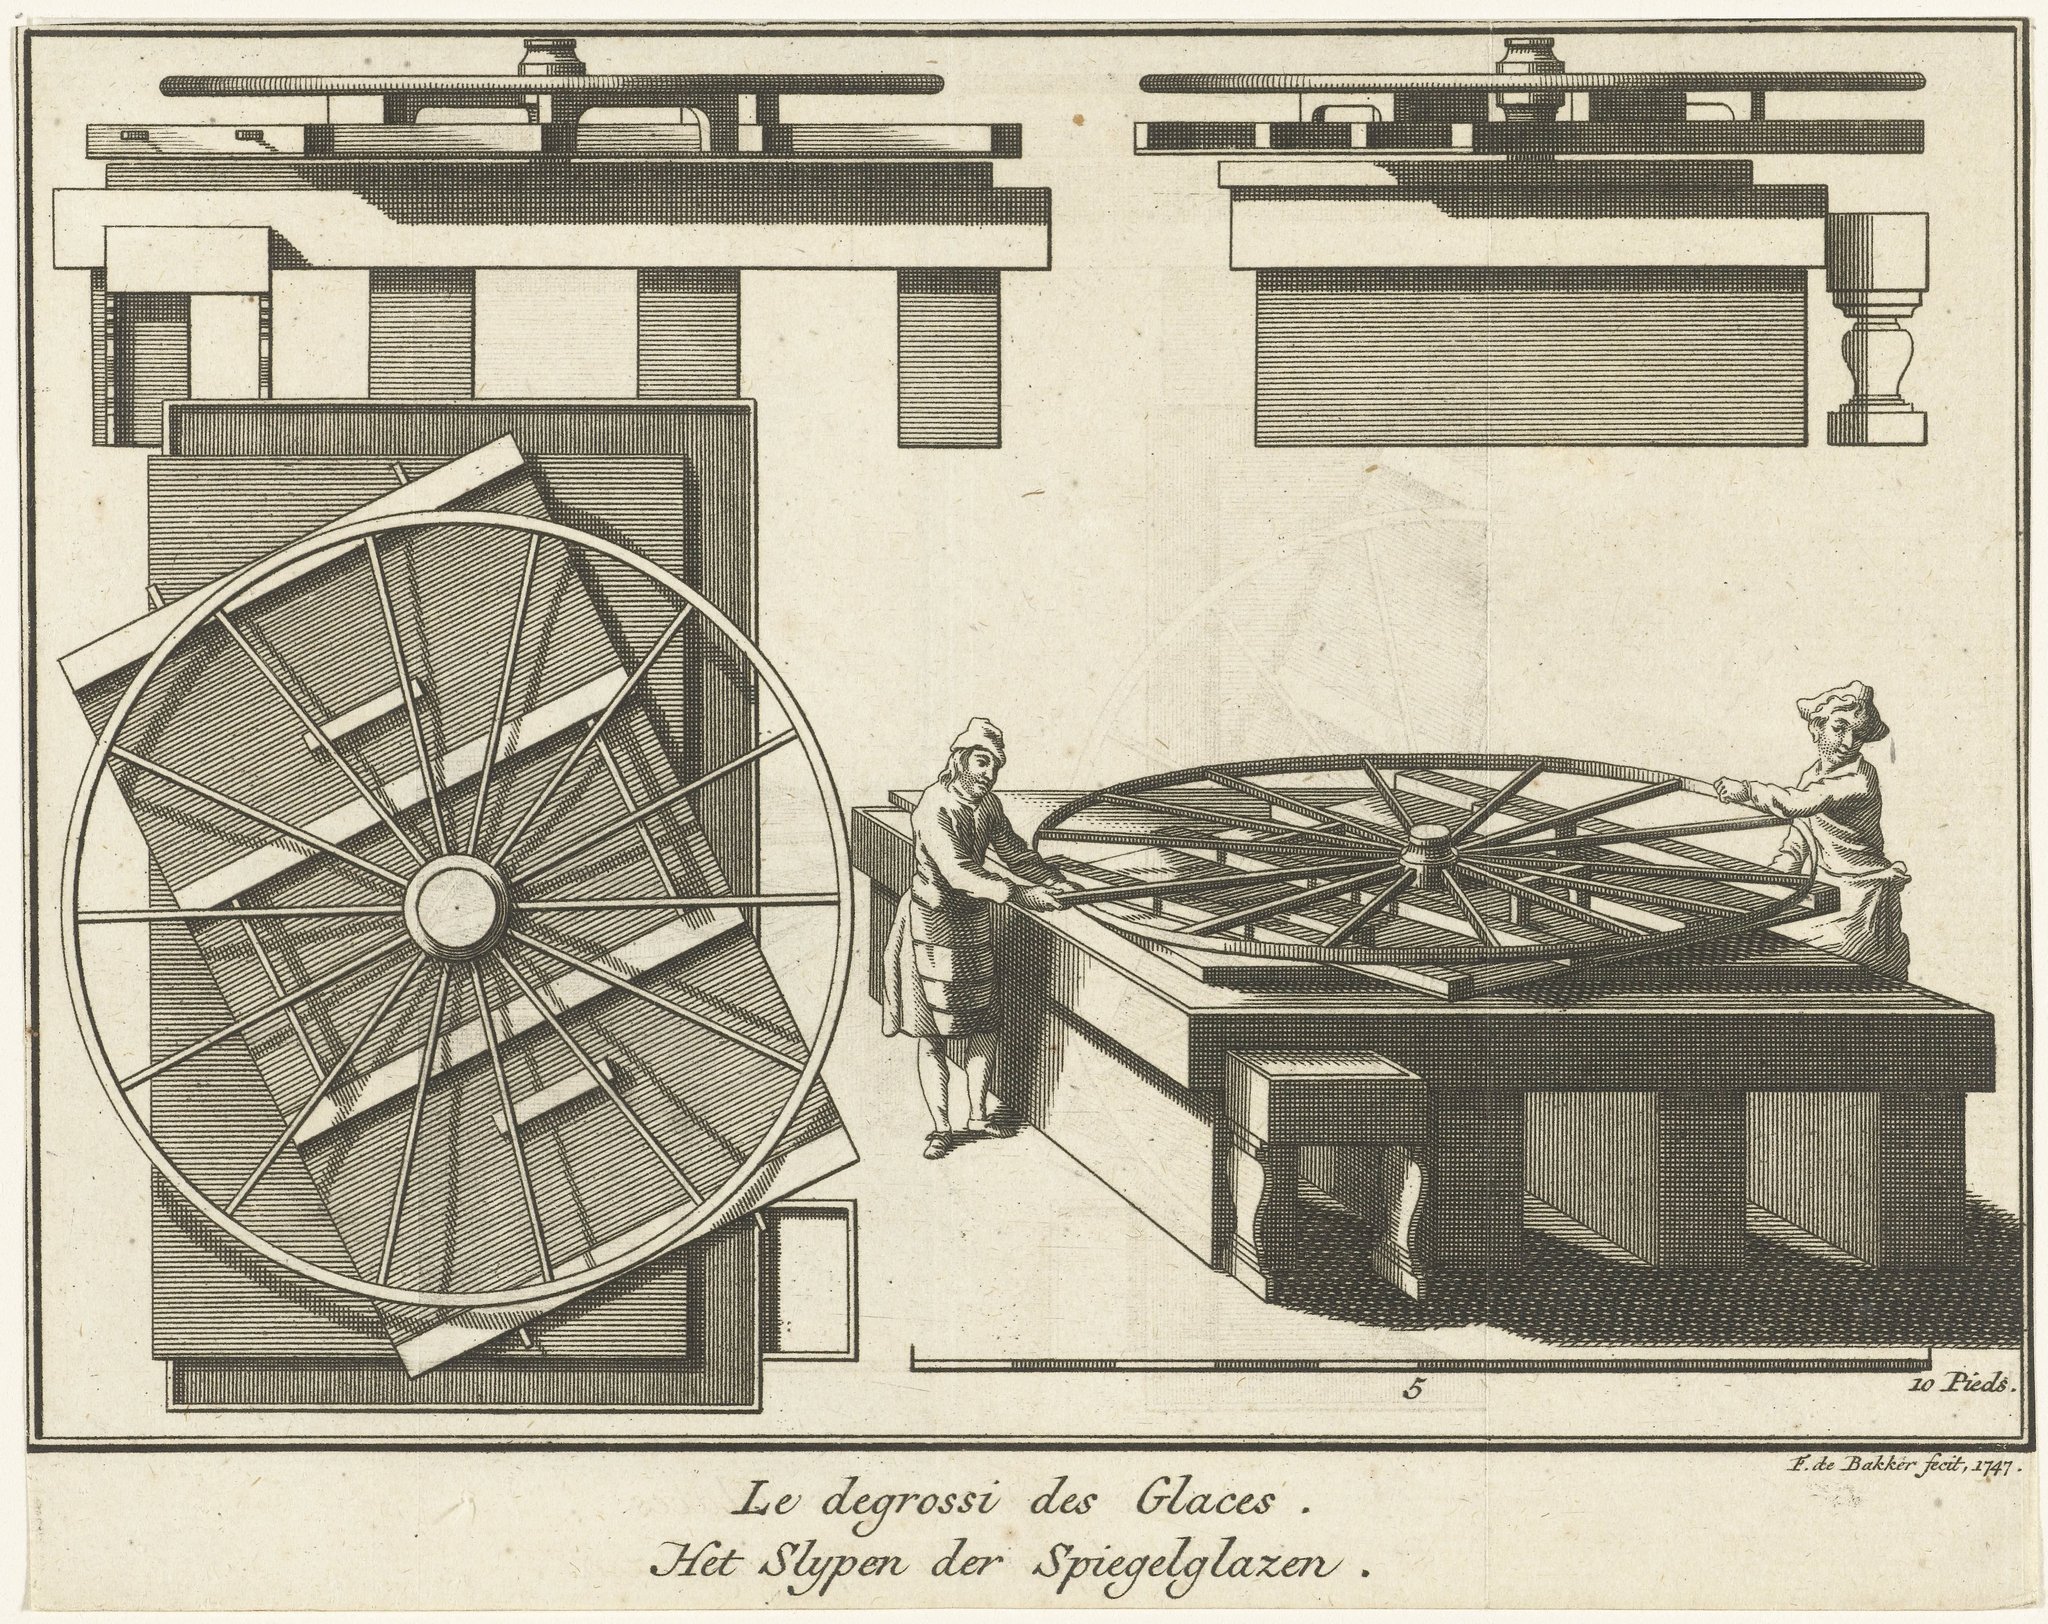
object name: print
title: Twee mannen aan een machine voor het slijpen van spiegels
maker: frans de bakker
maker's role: print maker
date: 1747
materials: paper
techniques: etching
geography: amsterdam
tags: handicrafts ~ glass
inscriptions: collector's mark: Lugt 2228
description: Prent uit een serie met voorstellingen van verschillende ambachten.